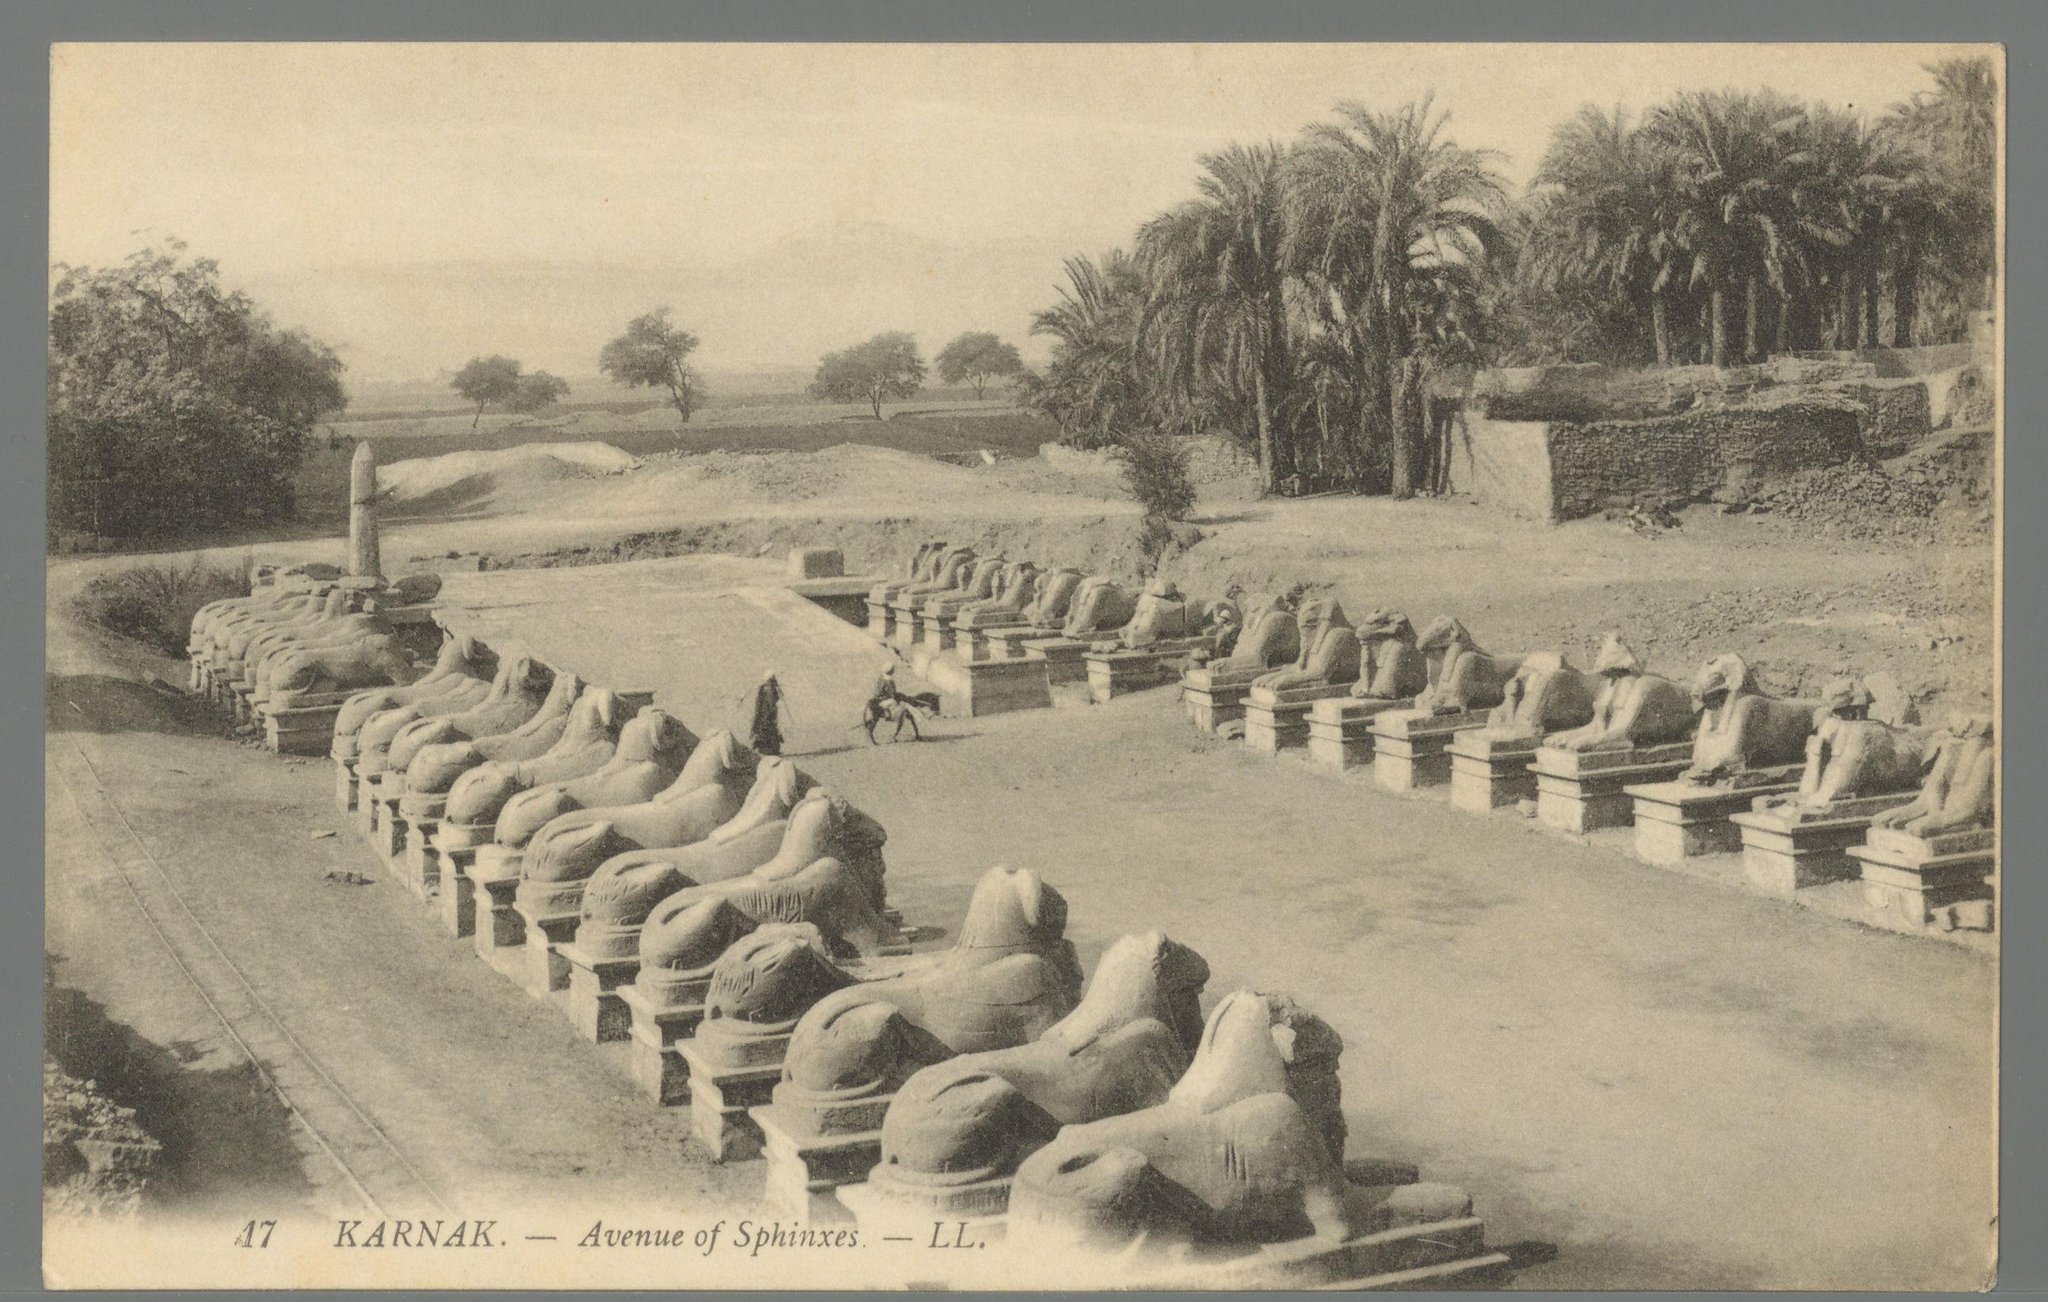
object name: ansichtkaart, prentbriefkaart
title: Karnak - Avenue of Sphinxes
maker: Anonymous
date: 1907-1930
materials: cardboard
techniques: photograph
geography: paris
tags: sphinx (lion/woman); 'sfinge' (ripa), statues, paintings, etc. ~ objects of worship (egyptian religion)